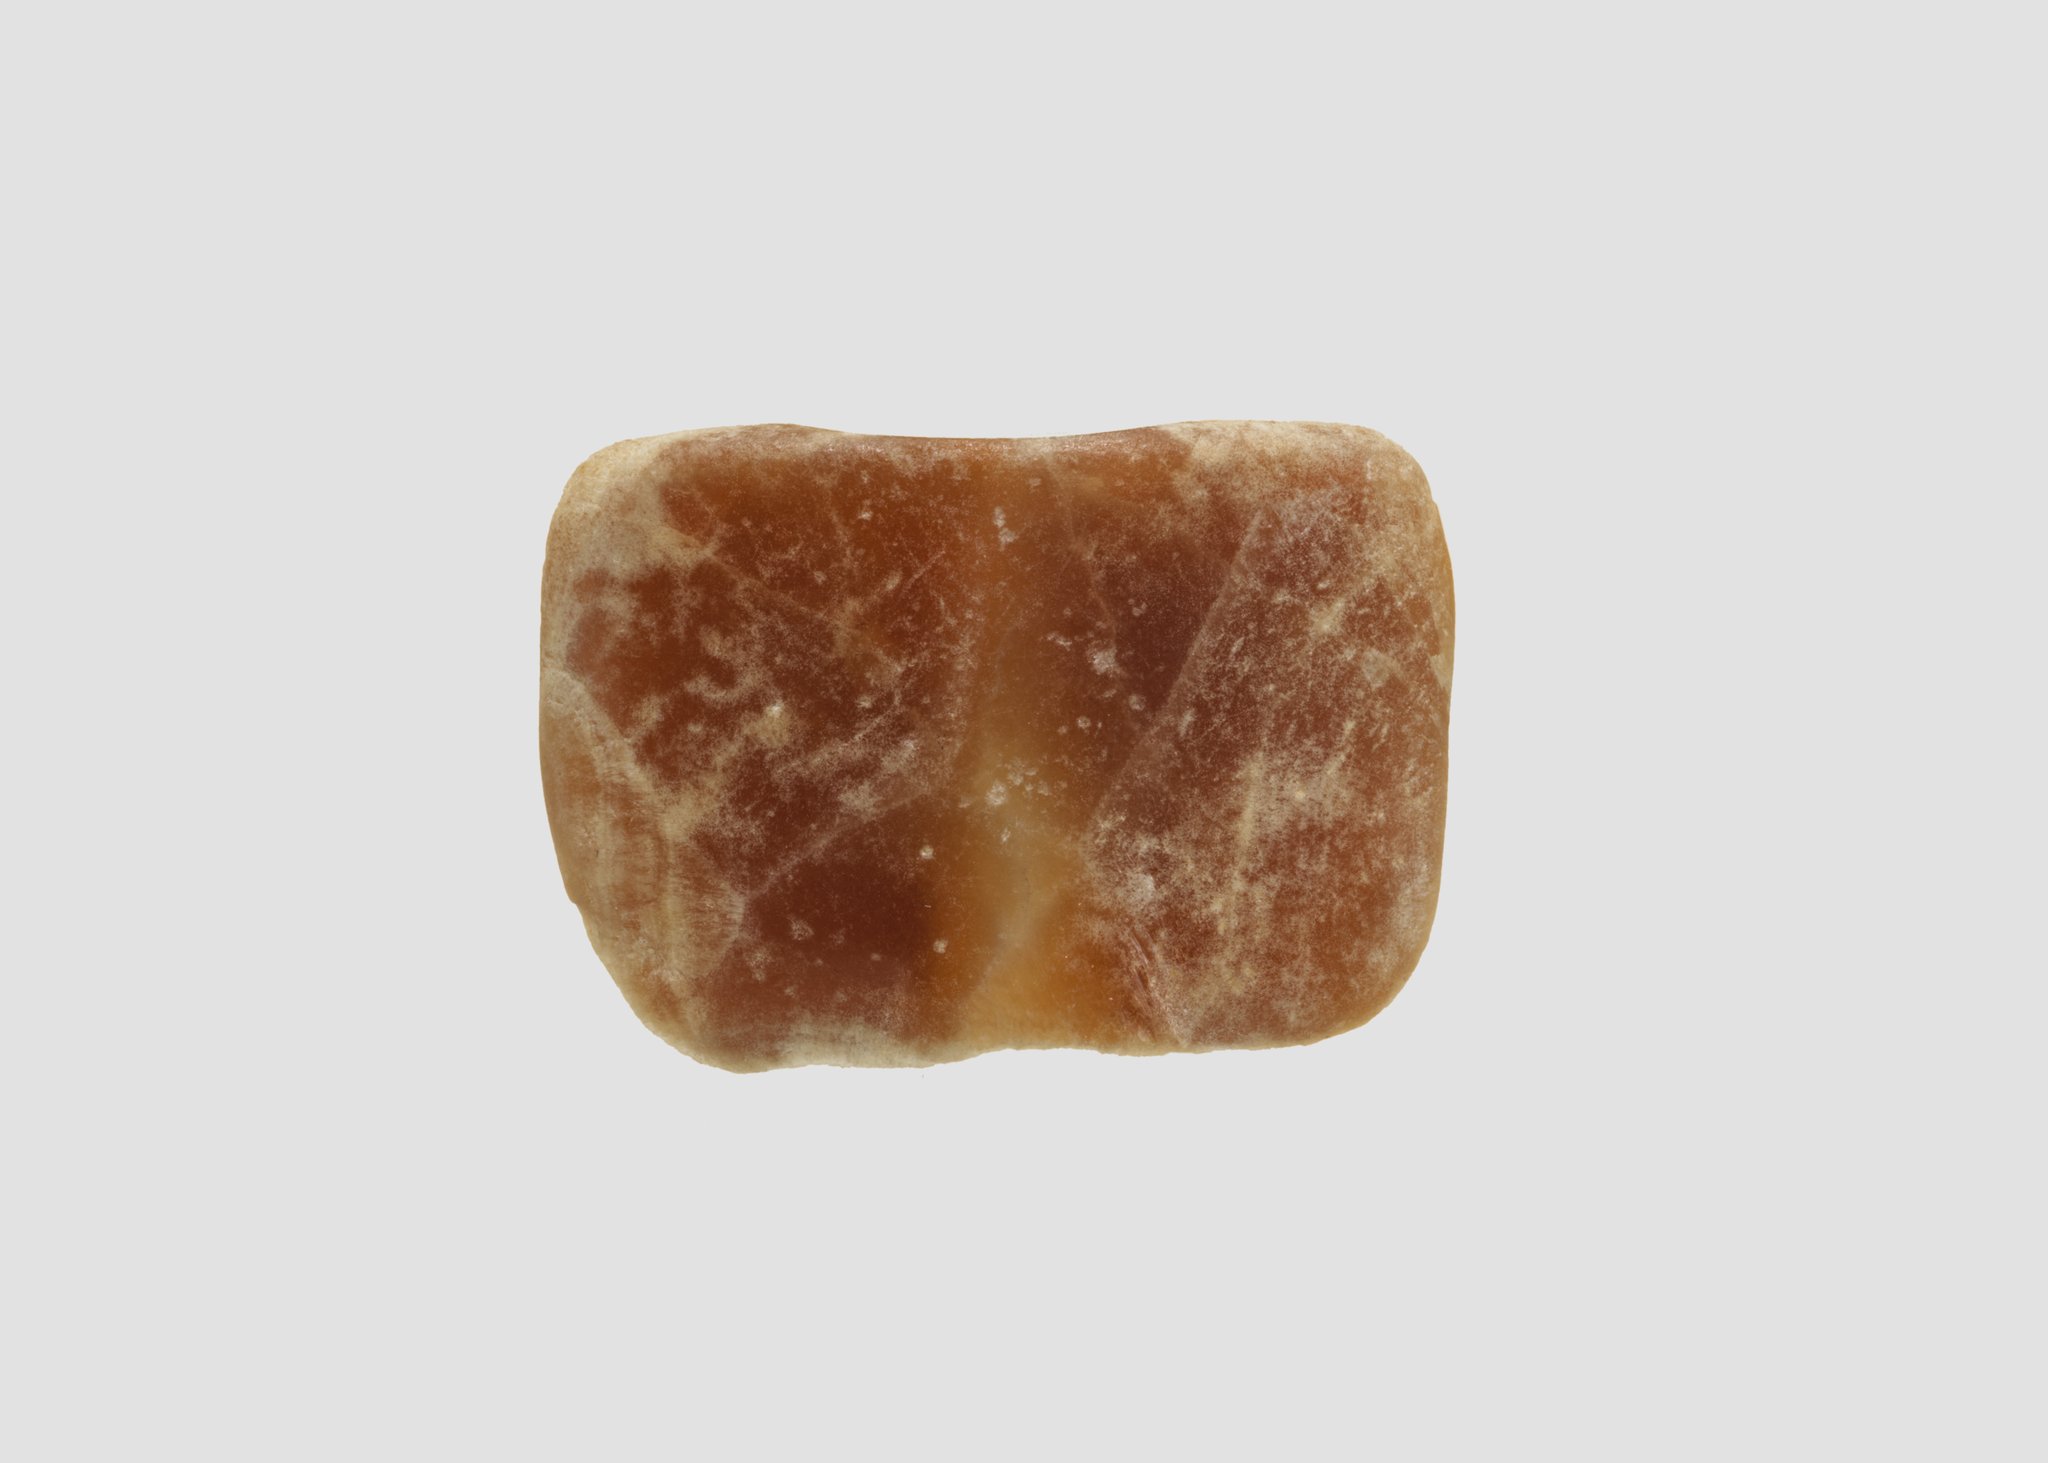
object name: bead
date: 7000-5001 BCE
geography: syria